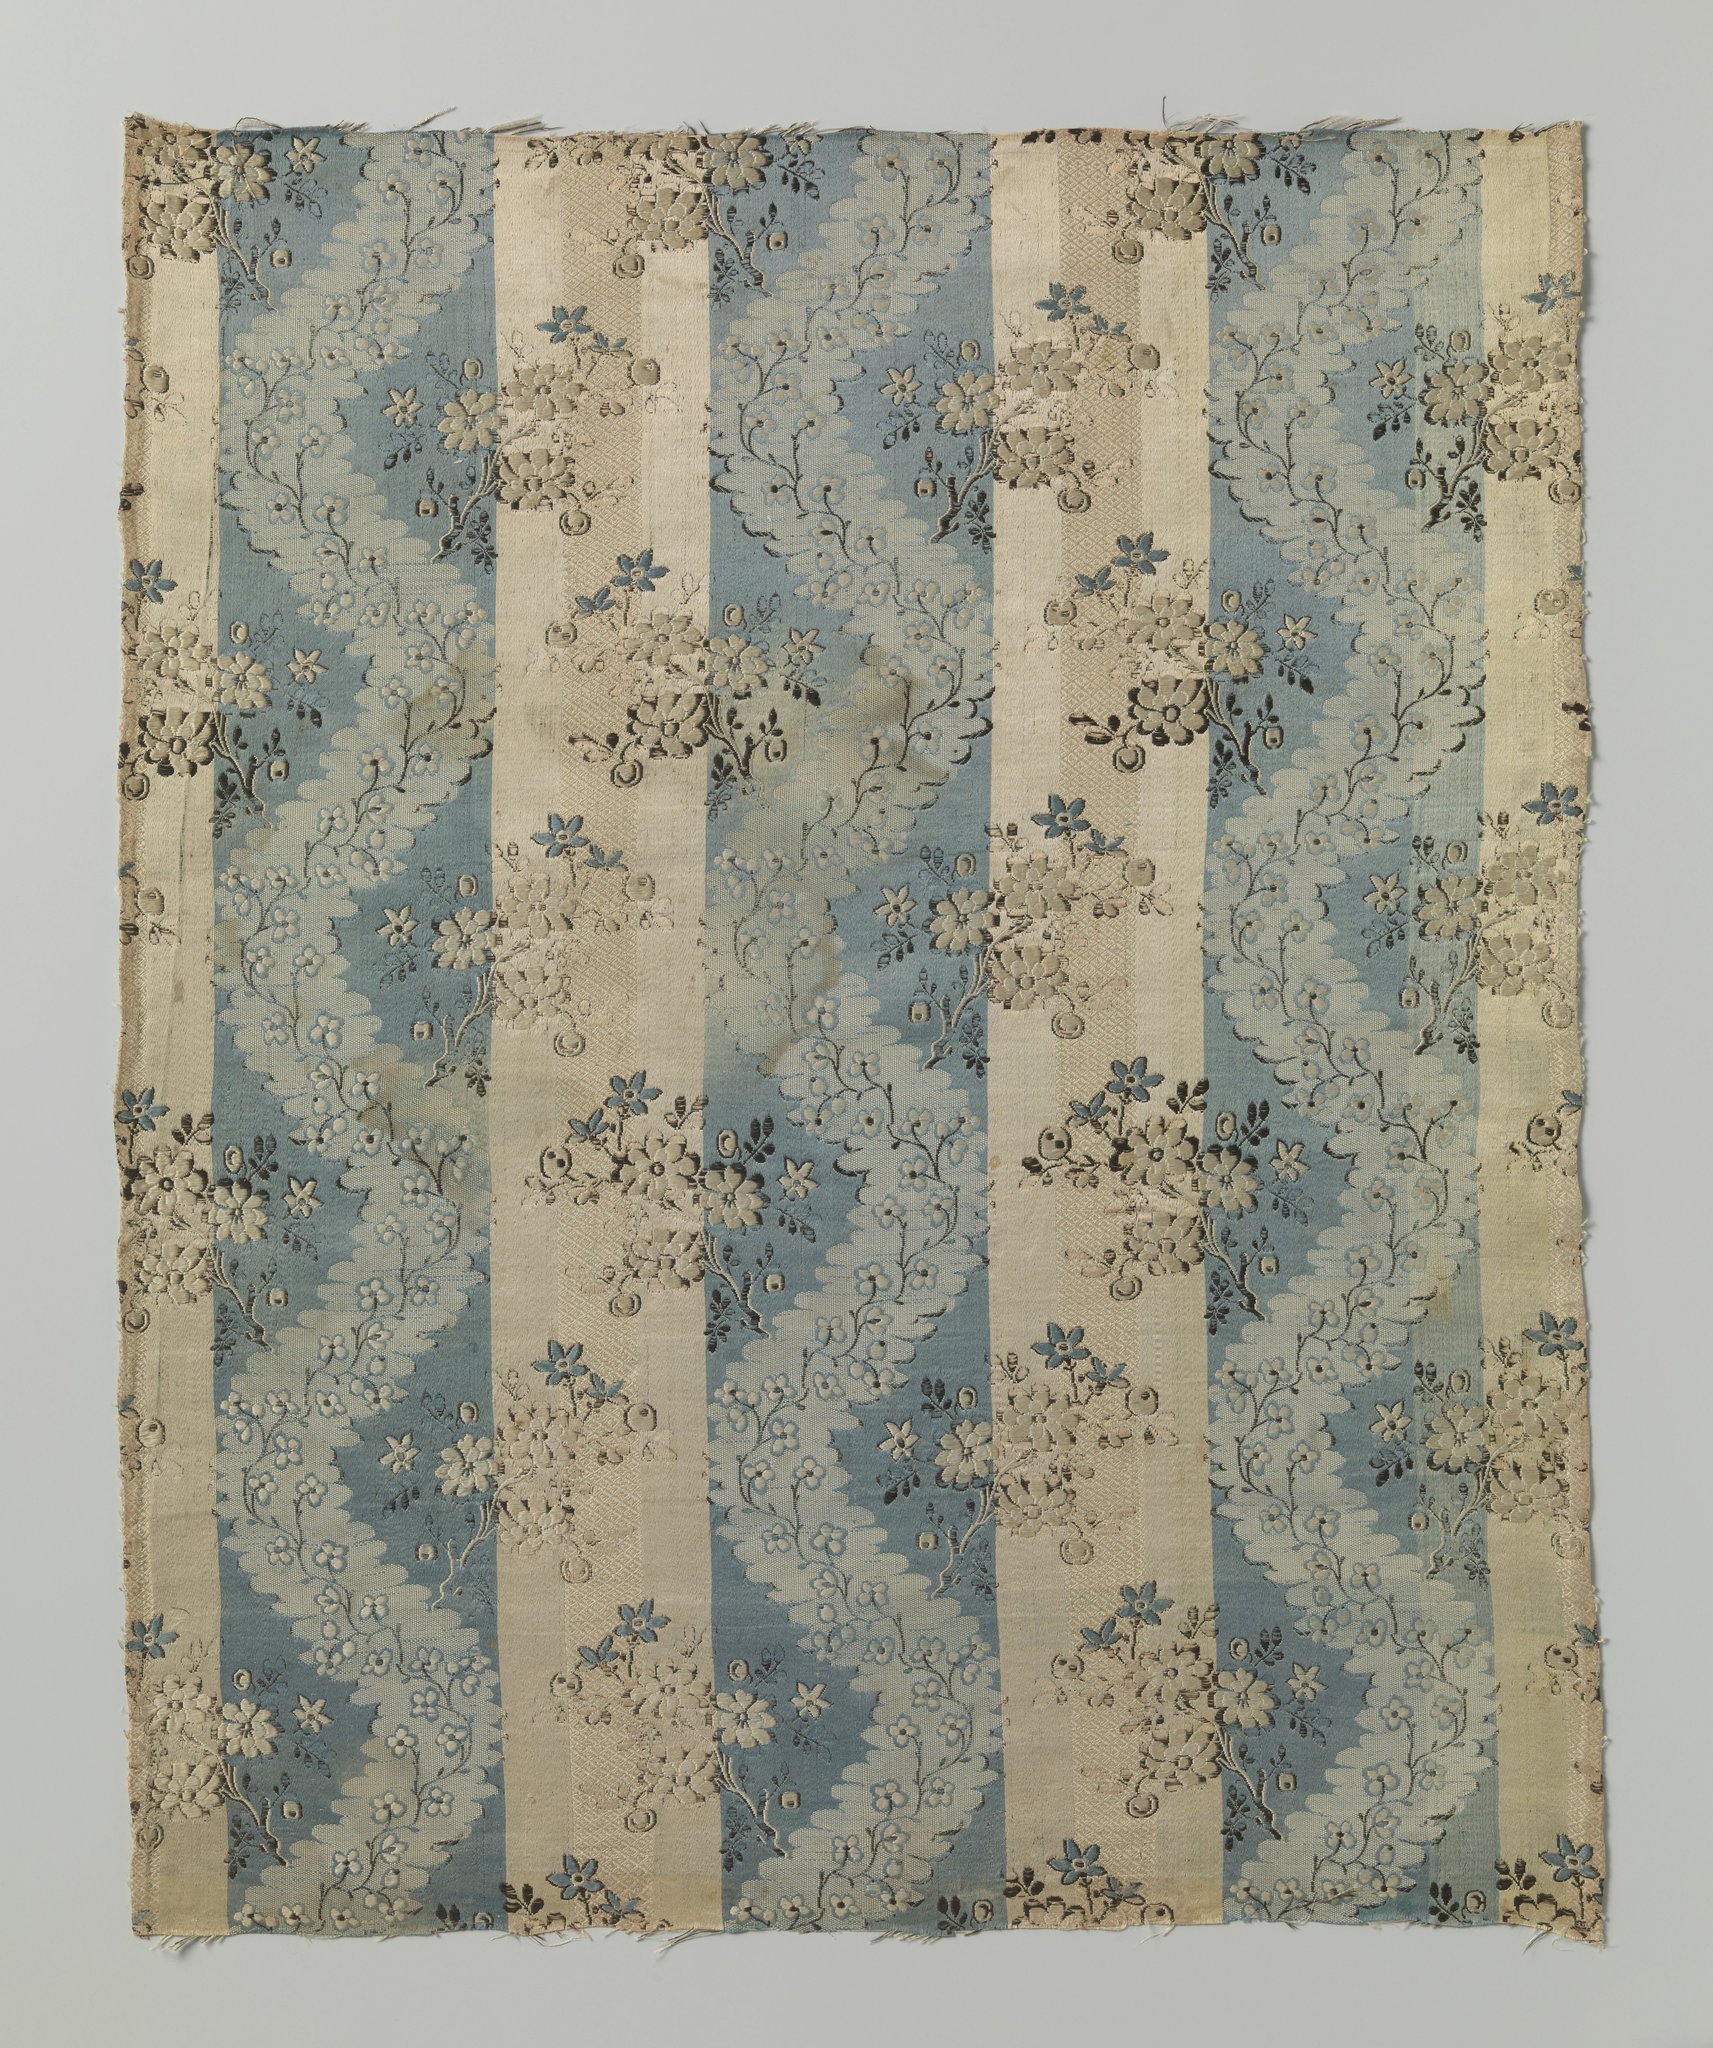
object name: zijdesatijn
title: Fragment van een veelkleurig zijdesatijn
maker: Anonymous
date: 1770-1780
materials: silk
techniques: launching, liseré, satin binding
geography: france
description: Een zijden weefsel met blauwe en créme strepen. Op de blauwe strepen is een slinger, waarin een doorlopende rank met zwarte stengels en witte bloemen. Losse takken van witte en blauwe bloemen zijn gedeeltelijk op de blauwe en witte strepen geweven. Opmerking: Zelfkanten; 0.3 cm effenbinding (meerdere kleuren in één sprong).